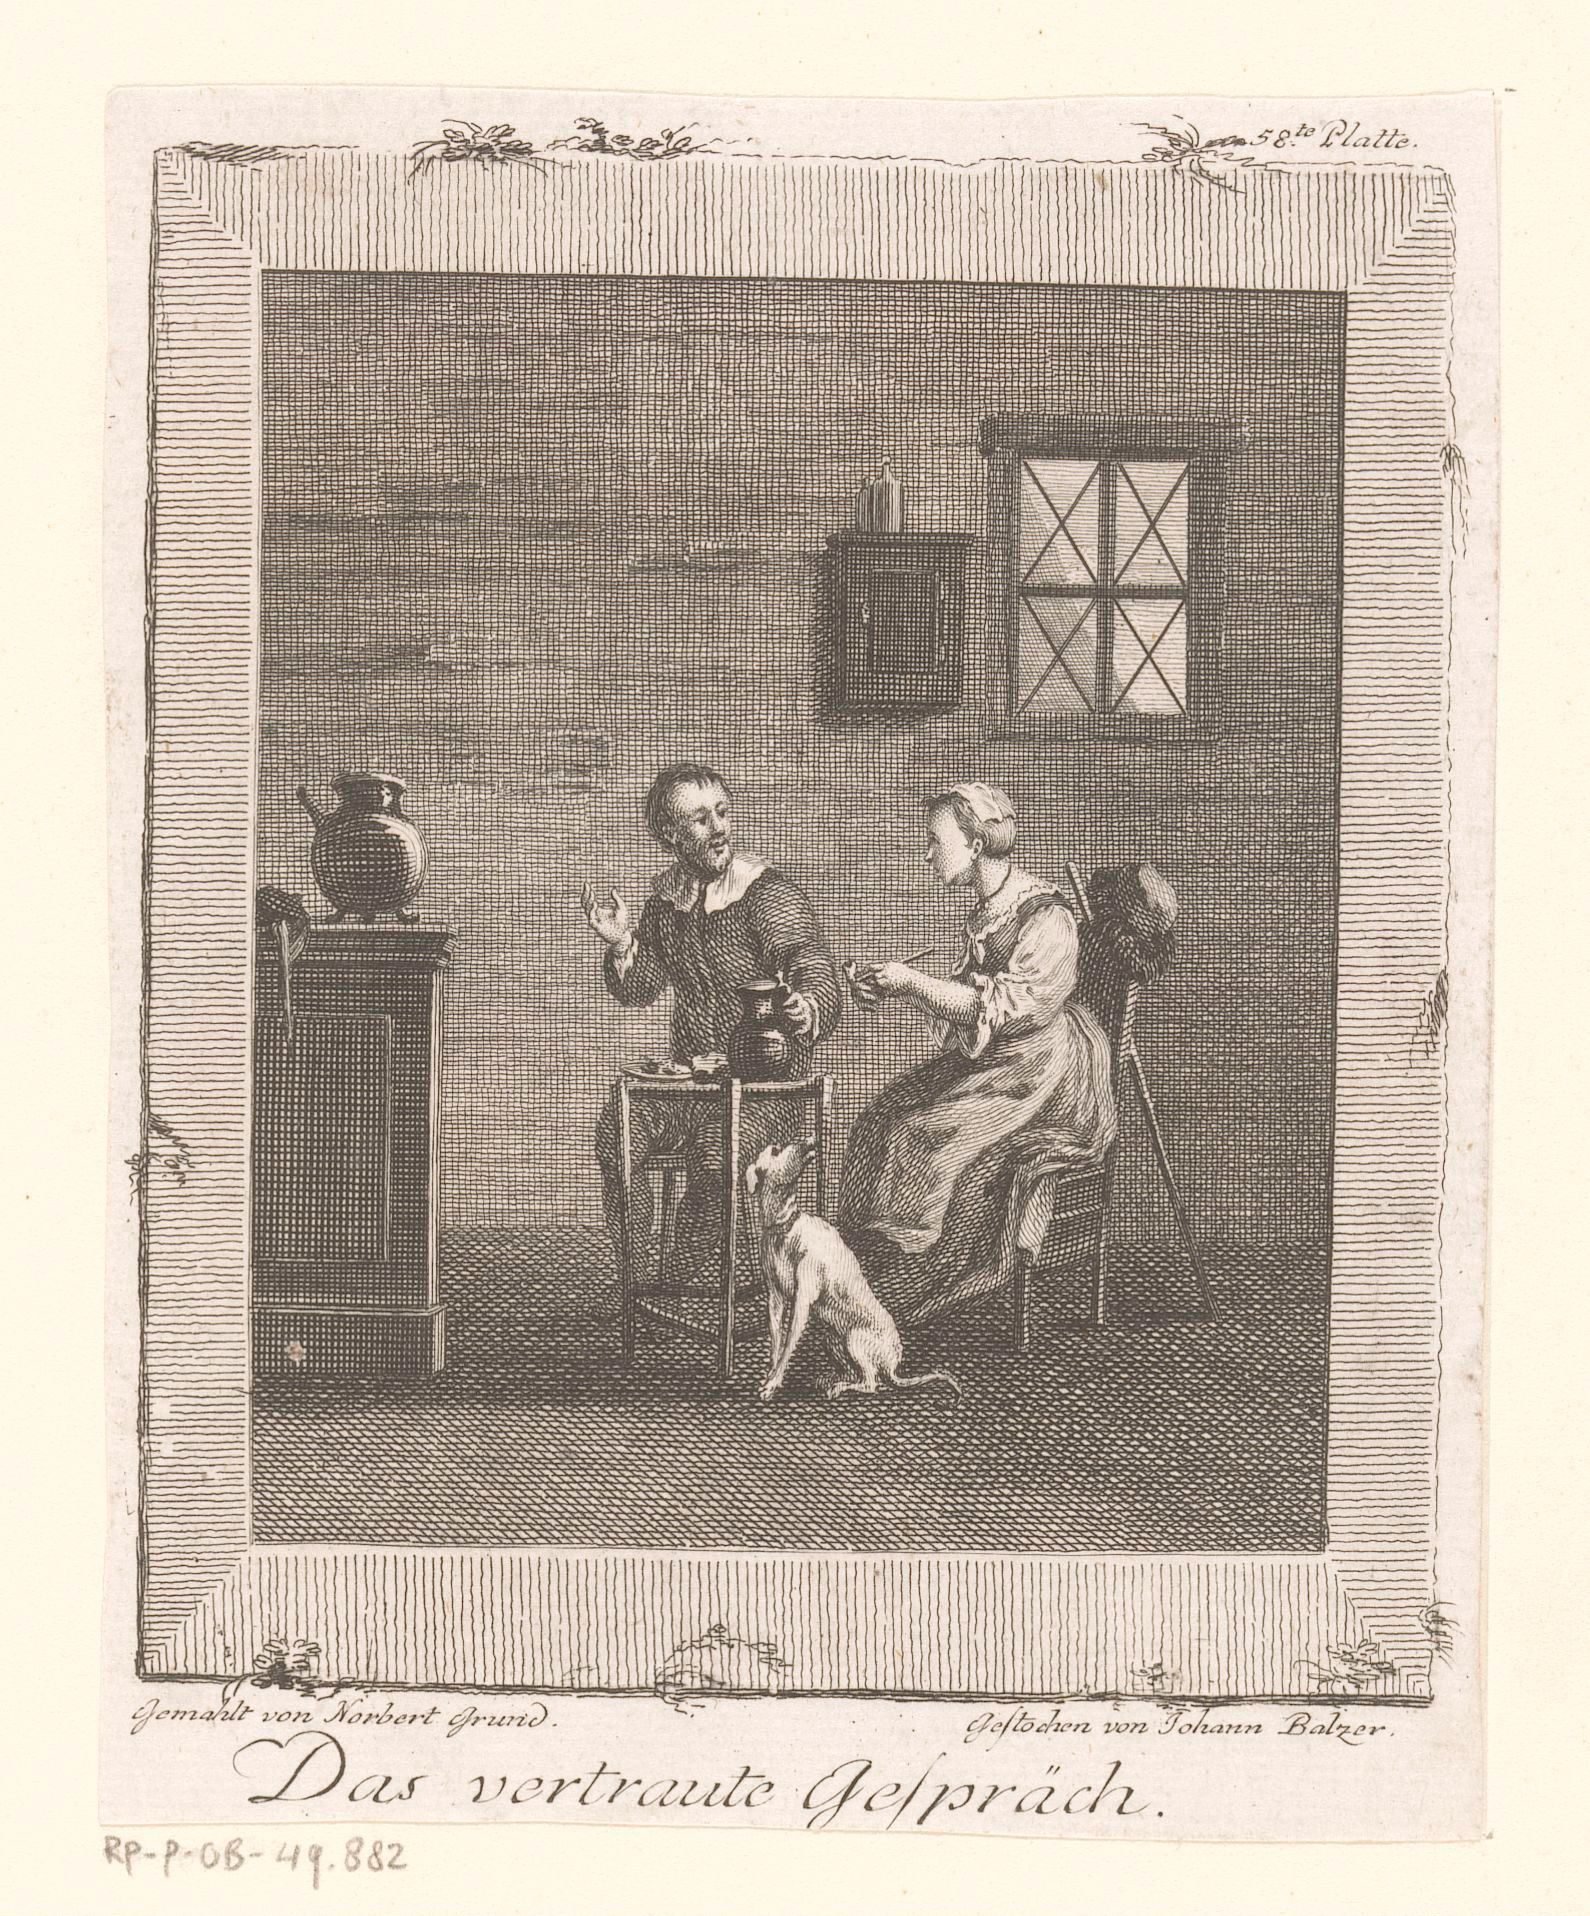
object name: print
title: Vertrouwlijk gesprek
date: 1746-1799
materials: paper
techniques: engraving, etching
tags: pipe ~ tobacco, interior of the house, conversation, dialogue; conversation piece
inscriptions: collector's mark: Lugt 2228